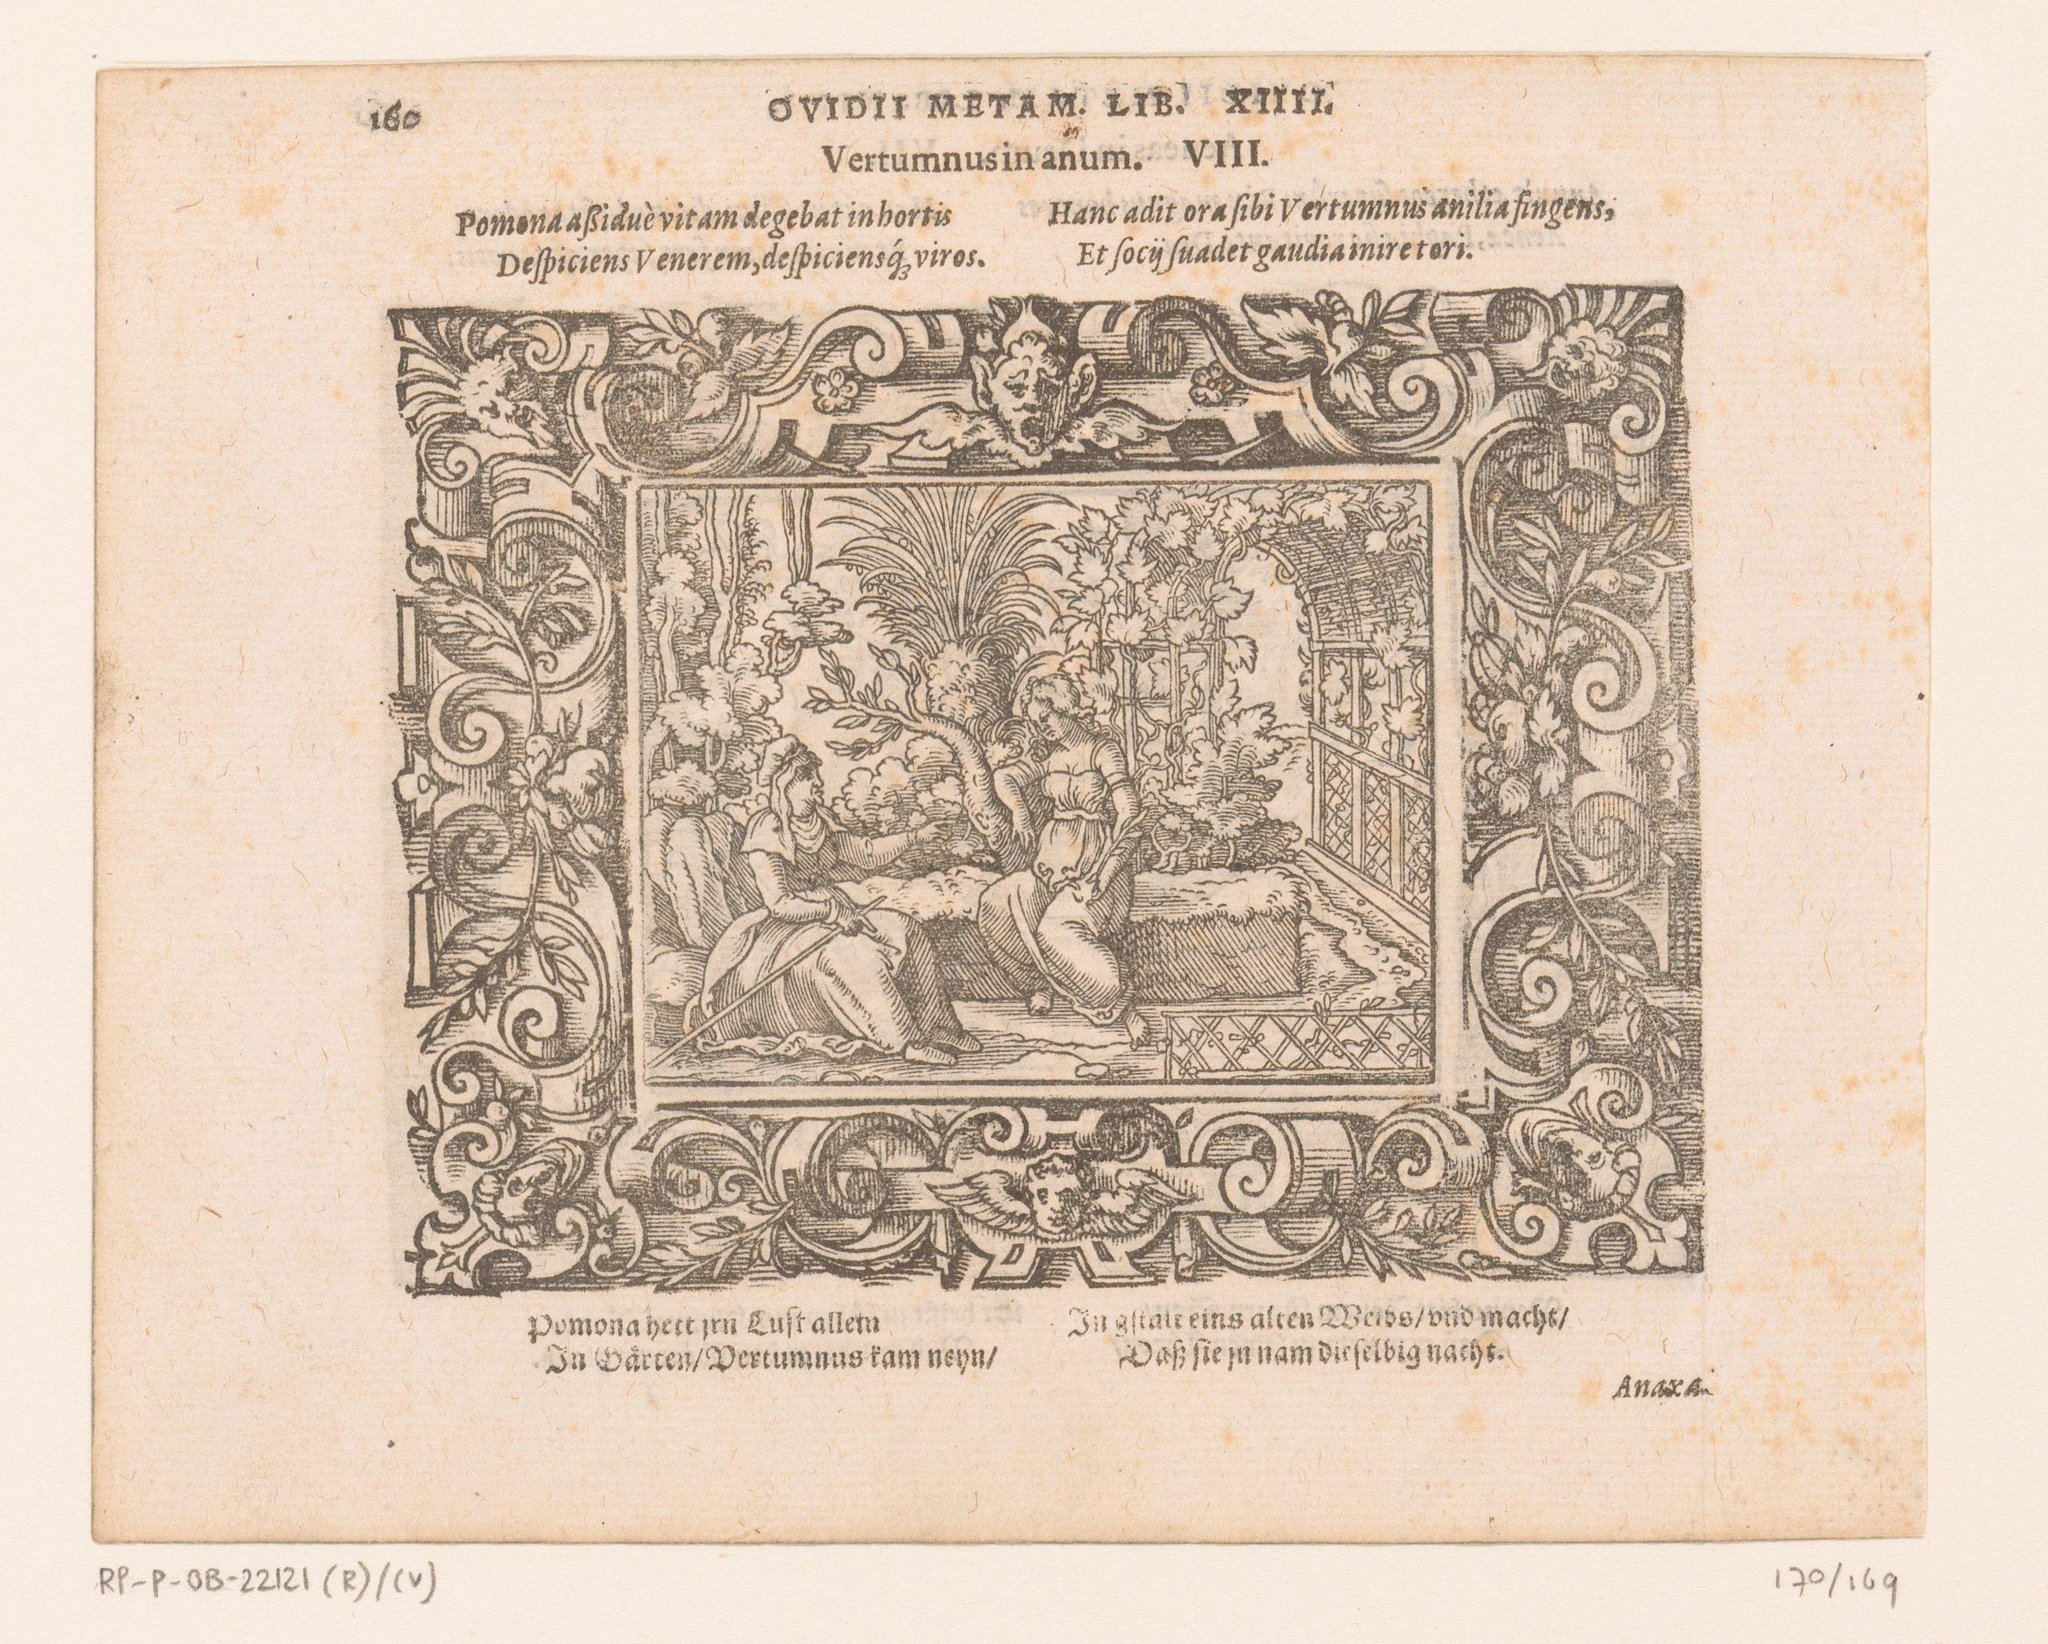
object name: print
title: Vertumnus en Pomona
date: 1569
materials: paper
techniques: letterpress printing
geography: frankfurt am main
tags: scrollwork, strapwork ~ ornament, vertumnus, in the guise of an old woman, wooing pomona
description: Illustratie bij de Metamorfosen van Ovidius, afkomstig uit de publicatie: Posthius, Johannes. Tetrasticha in Ovidii metam. Frankfurt am Main: Georg Rab en Sigmund Feyerabend en erven Weigand Han, 1569. De voorstellingen en ornamentranden van deze boekillustraties zijn van twee aparte blokken gedrukt. Beide werden afzonderlijk van elkaar ook gebruikt voor andere publicaties, en de ornamentranden werden eveneens binnen deze publicatie meerdere keren gebruikt.